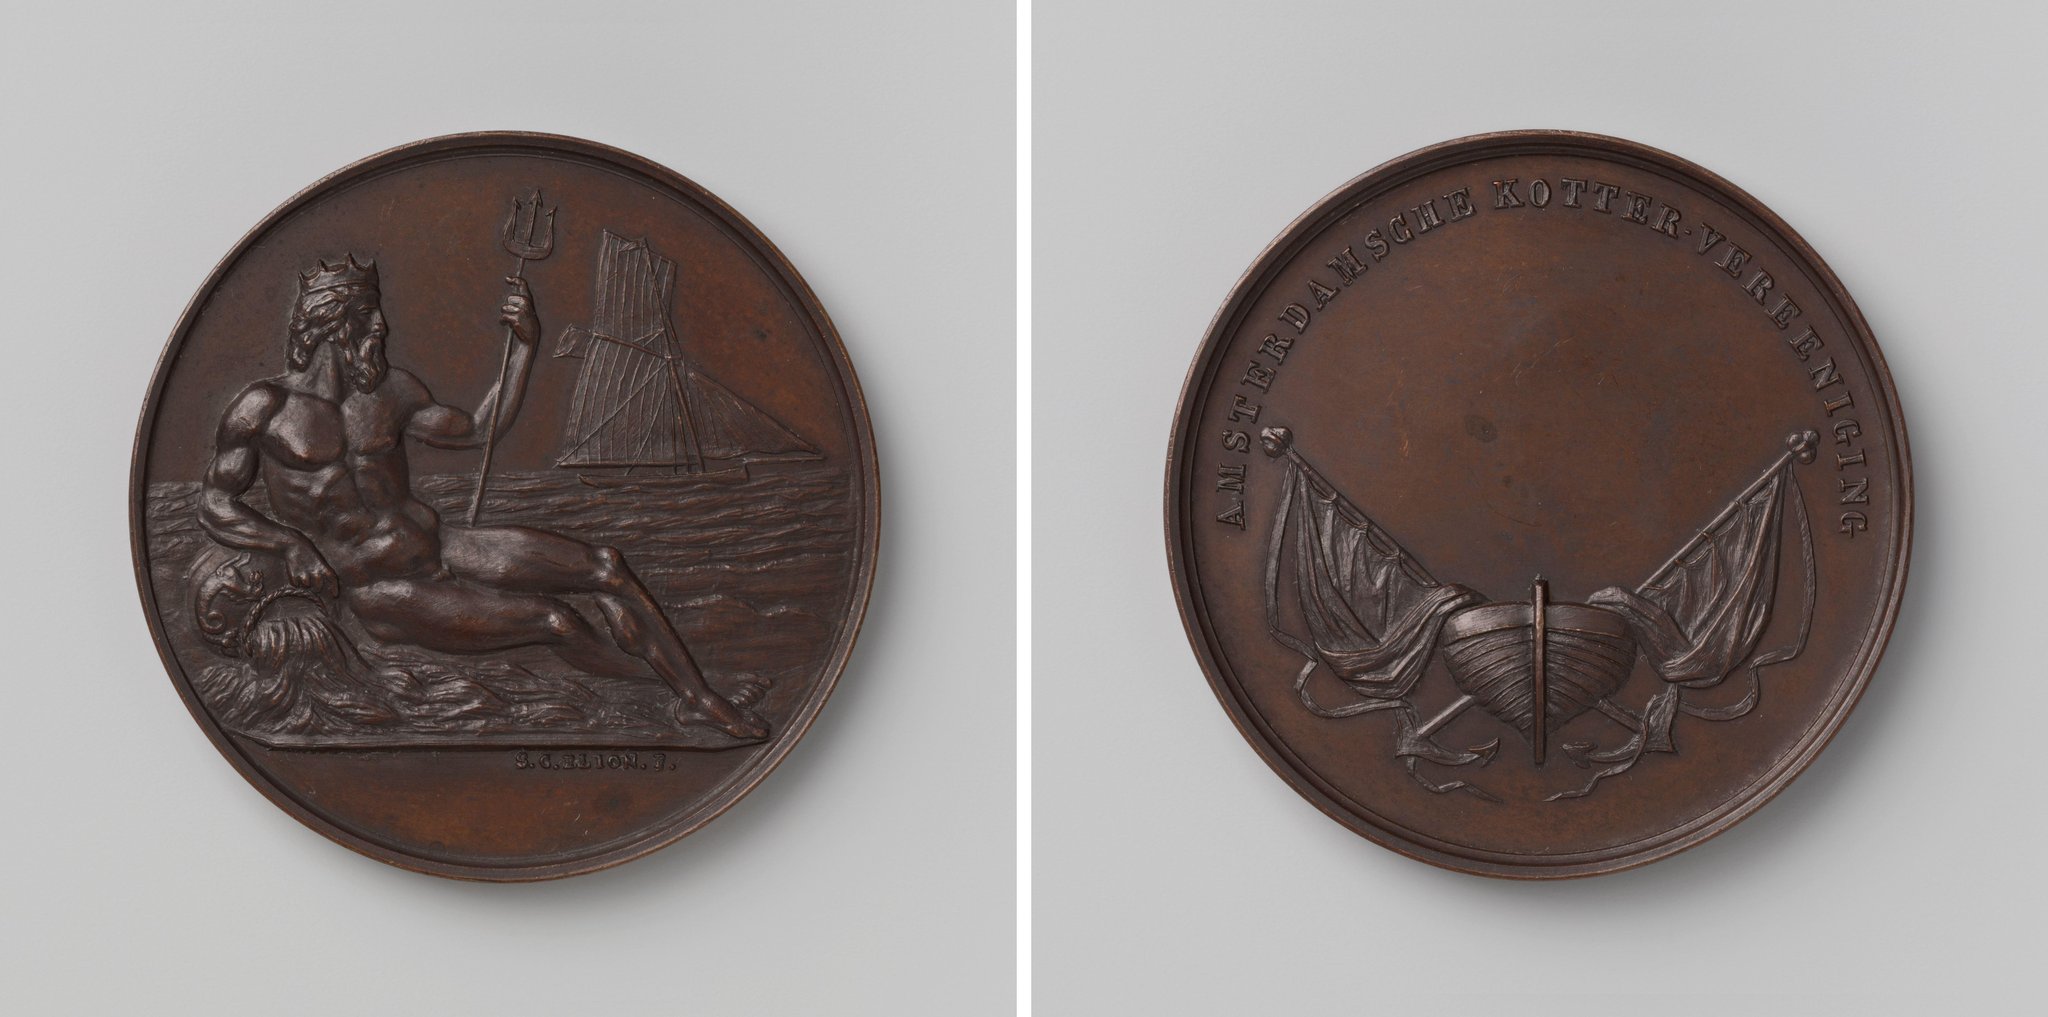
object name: medal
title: Amsterdamsche Kottervereniging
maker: samuel cohen elion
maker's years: 1815-1880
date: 1850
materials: bronze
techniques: striking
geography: amsterdam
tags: amsterdam